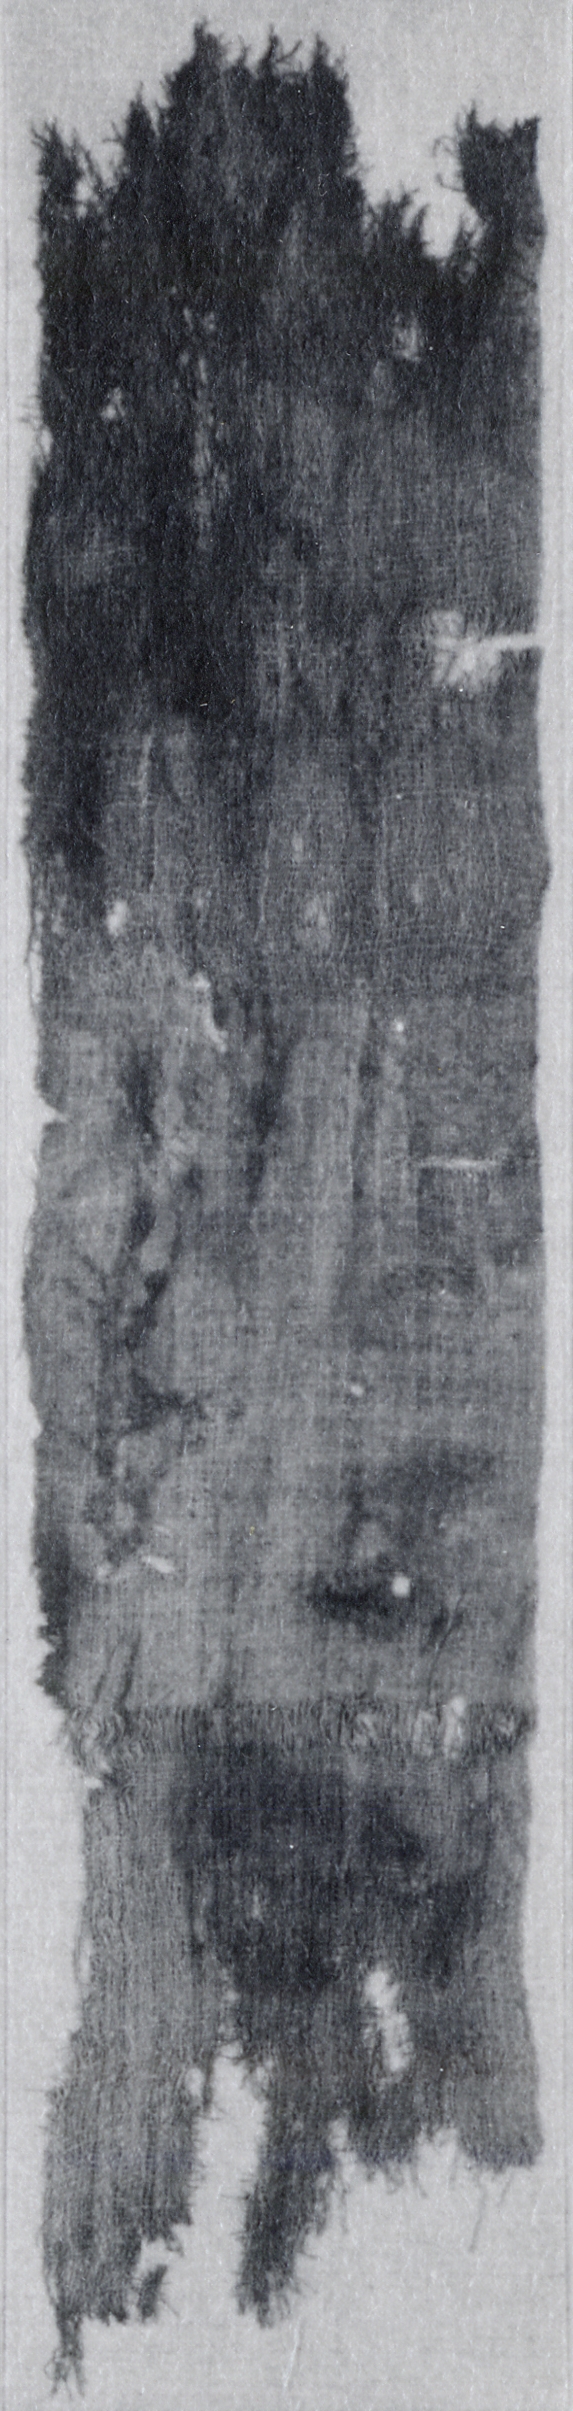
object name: fragment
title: Sheet Fragment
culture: coptic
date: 301-400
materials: linen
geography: egypt